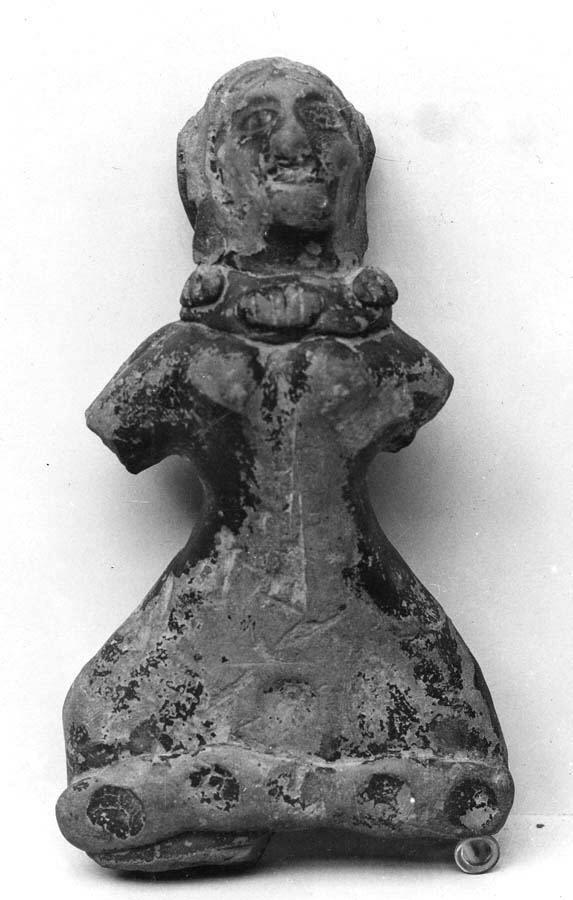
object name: statuette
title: Female Deity (Mother Goddess)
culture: indian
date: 300-101 BCE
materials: terracotta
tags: maurya,mauryan,goddess